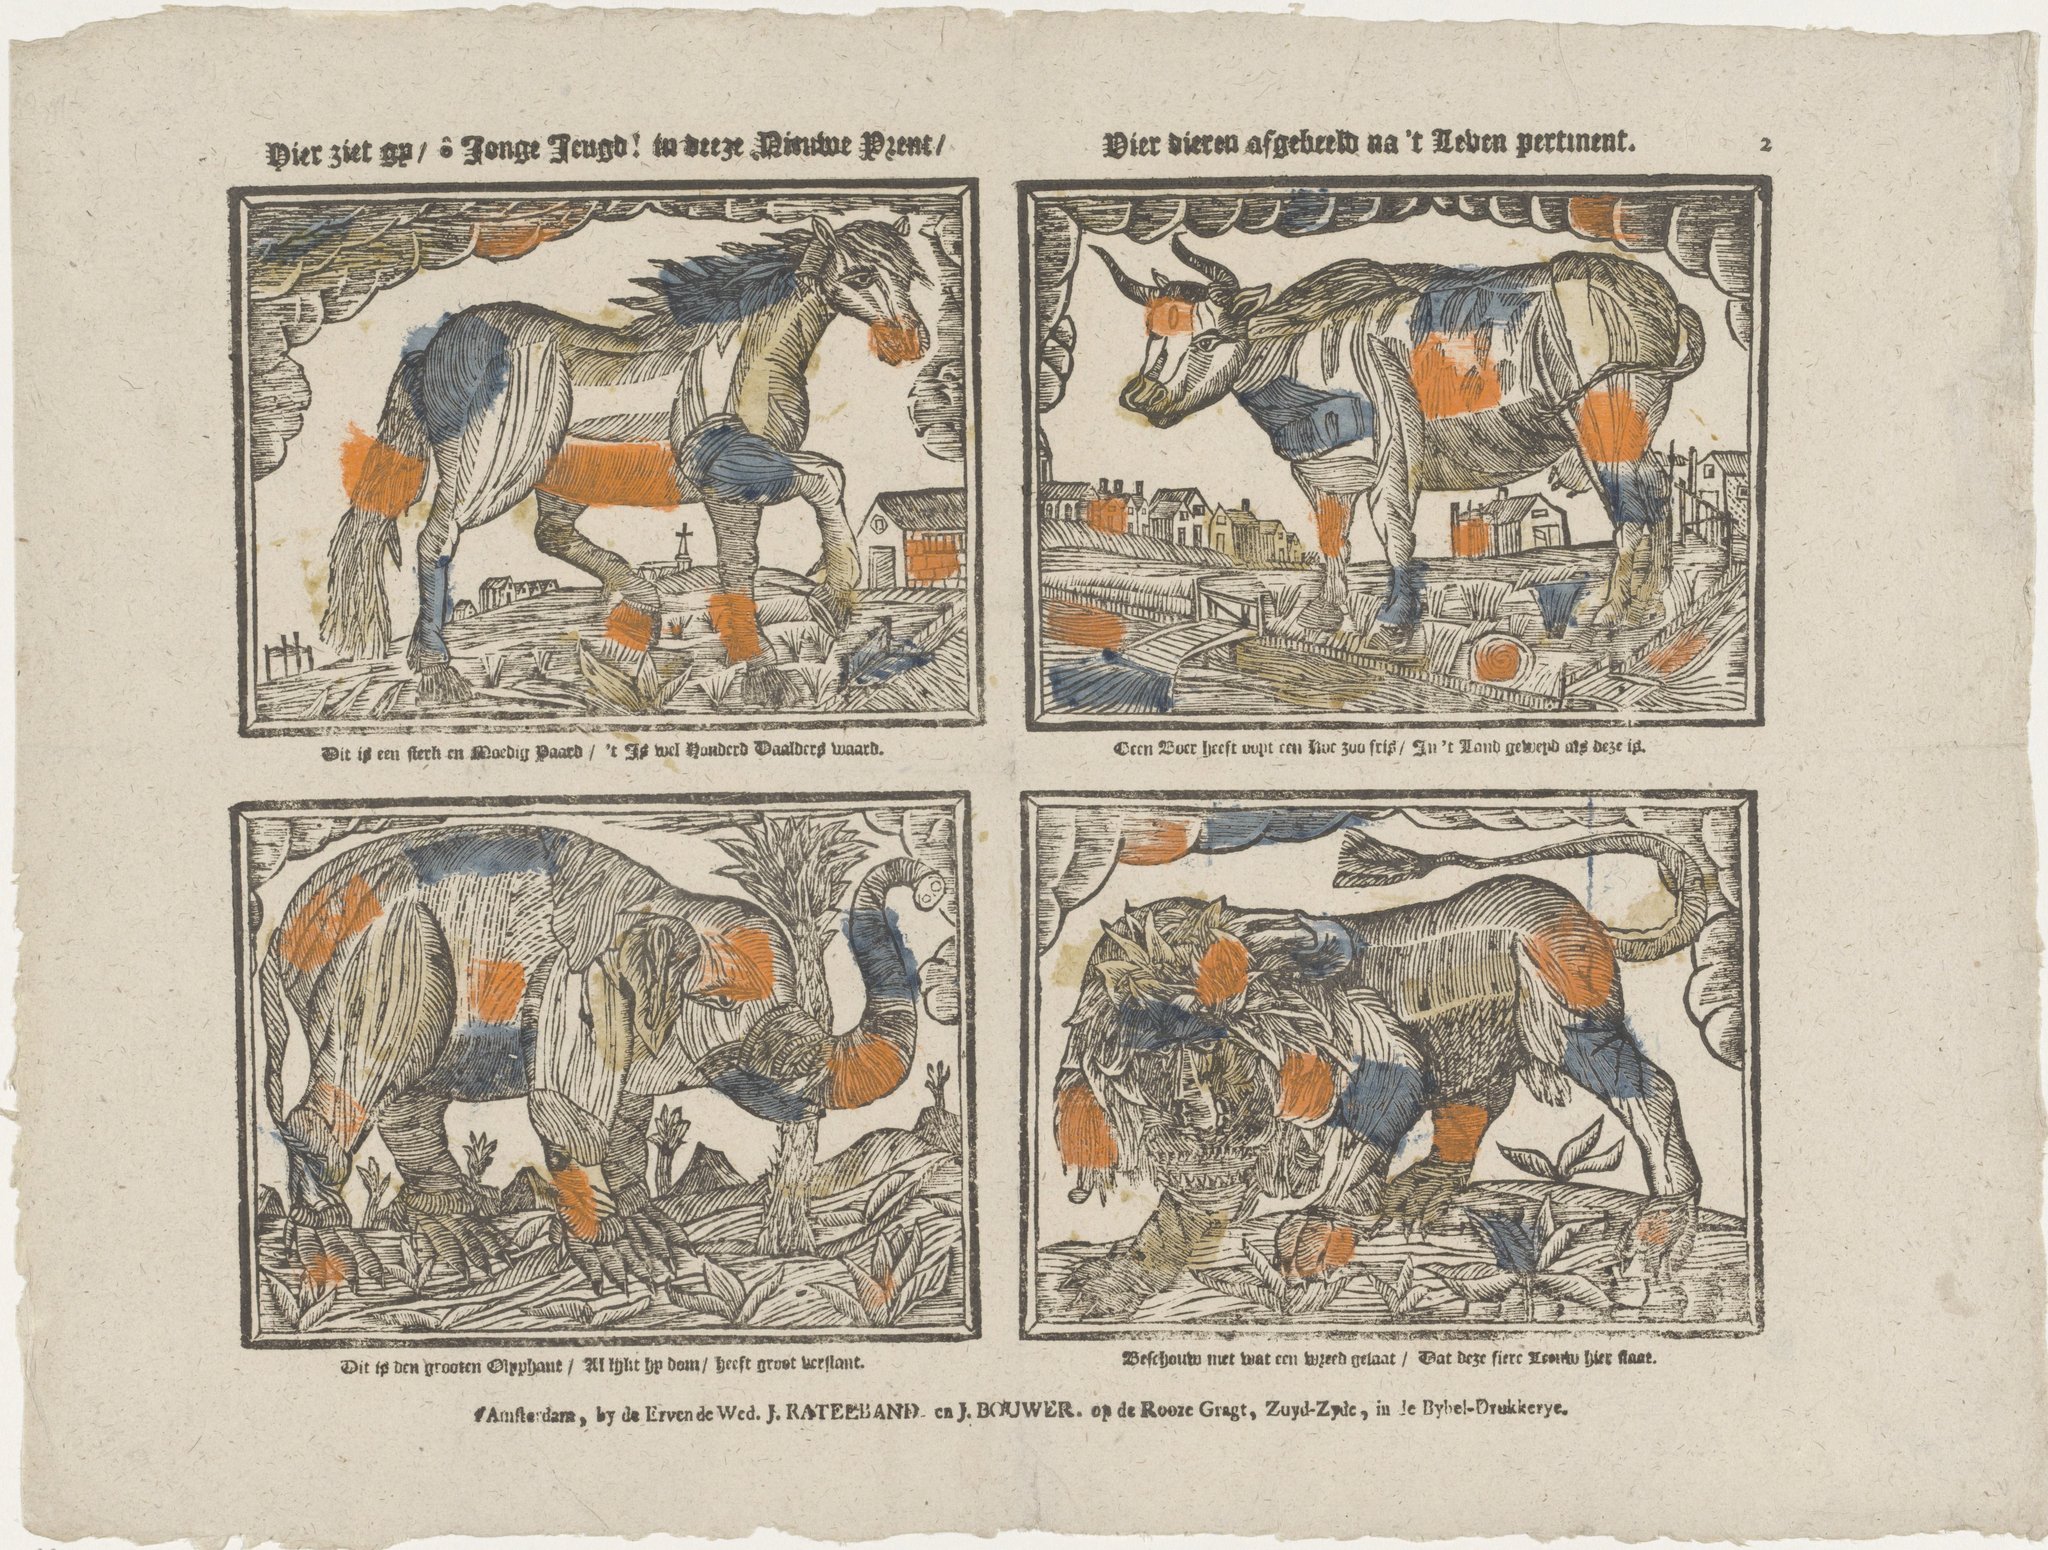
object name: print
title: Hier ziet gy / ô jonge jeugd! in deeze nieuwe prent / Vier dieren afgebeeld na 't leven pertinent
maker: Anonymous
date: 1760-1767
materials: paper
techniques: colour, letterpress printing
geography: amsterdam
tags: cow, animals, horse, beasts of prey, predatory animals: lion, trunked animals: elephant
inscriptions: collector's mark: Lugt 2760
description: Blad met 4 voorstellingen van dieren: een paard, een koe, een olifant en een leeuw. Onder elke afbeelding een tweeregelig vers. Genummerd rechtsboven: 2.